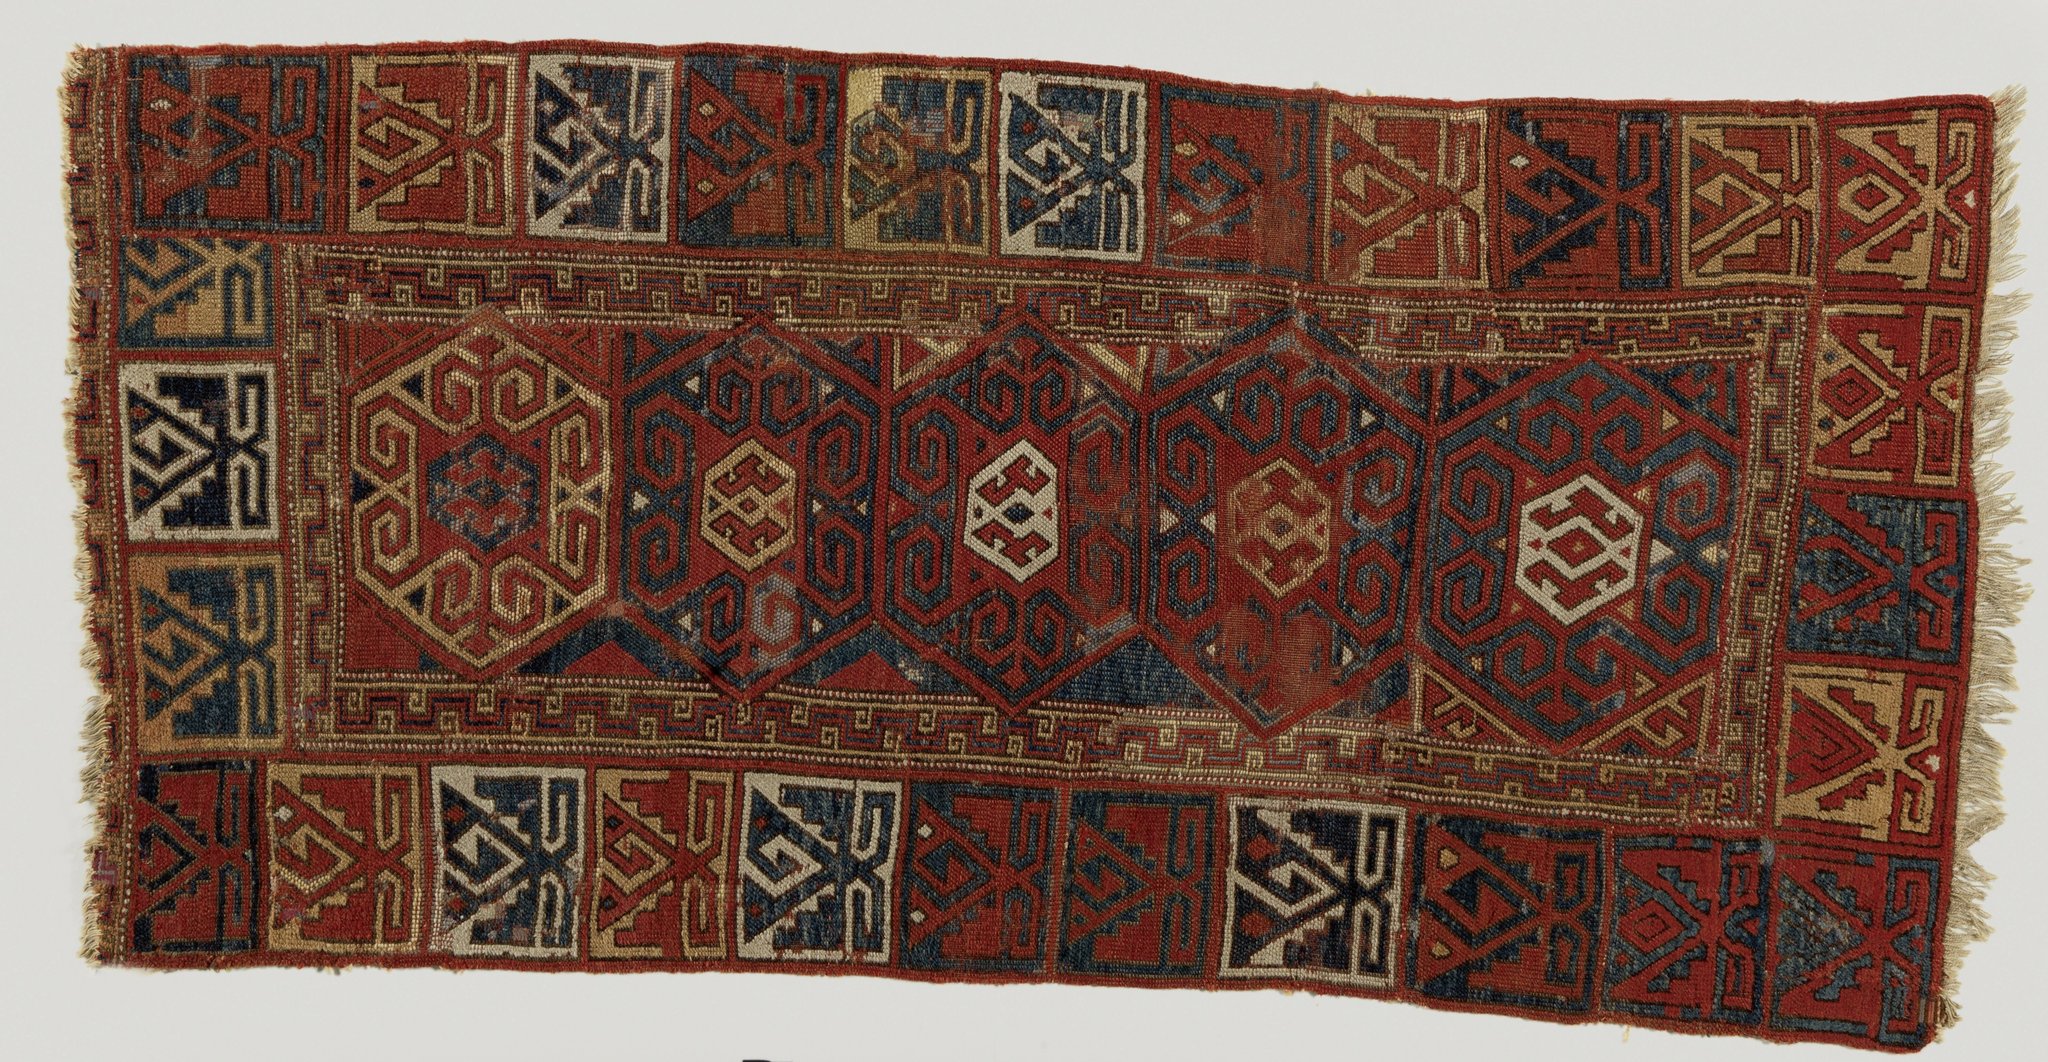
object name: oriental rug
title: Oosters tapijt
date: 1800-1900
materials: wool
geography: konya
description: Oosters tapijt (fragment), zeshoekig medaillonkleed. Op het middenveld staan vijf zeshoekige medaillons, gevormd door haakfiguren tegen een oranjerood fond. De brede rand is versierd met vierkante opgebouwd uit haakmotieven.